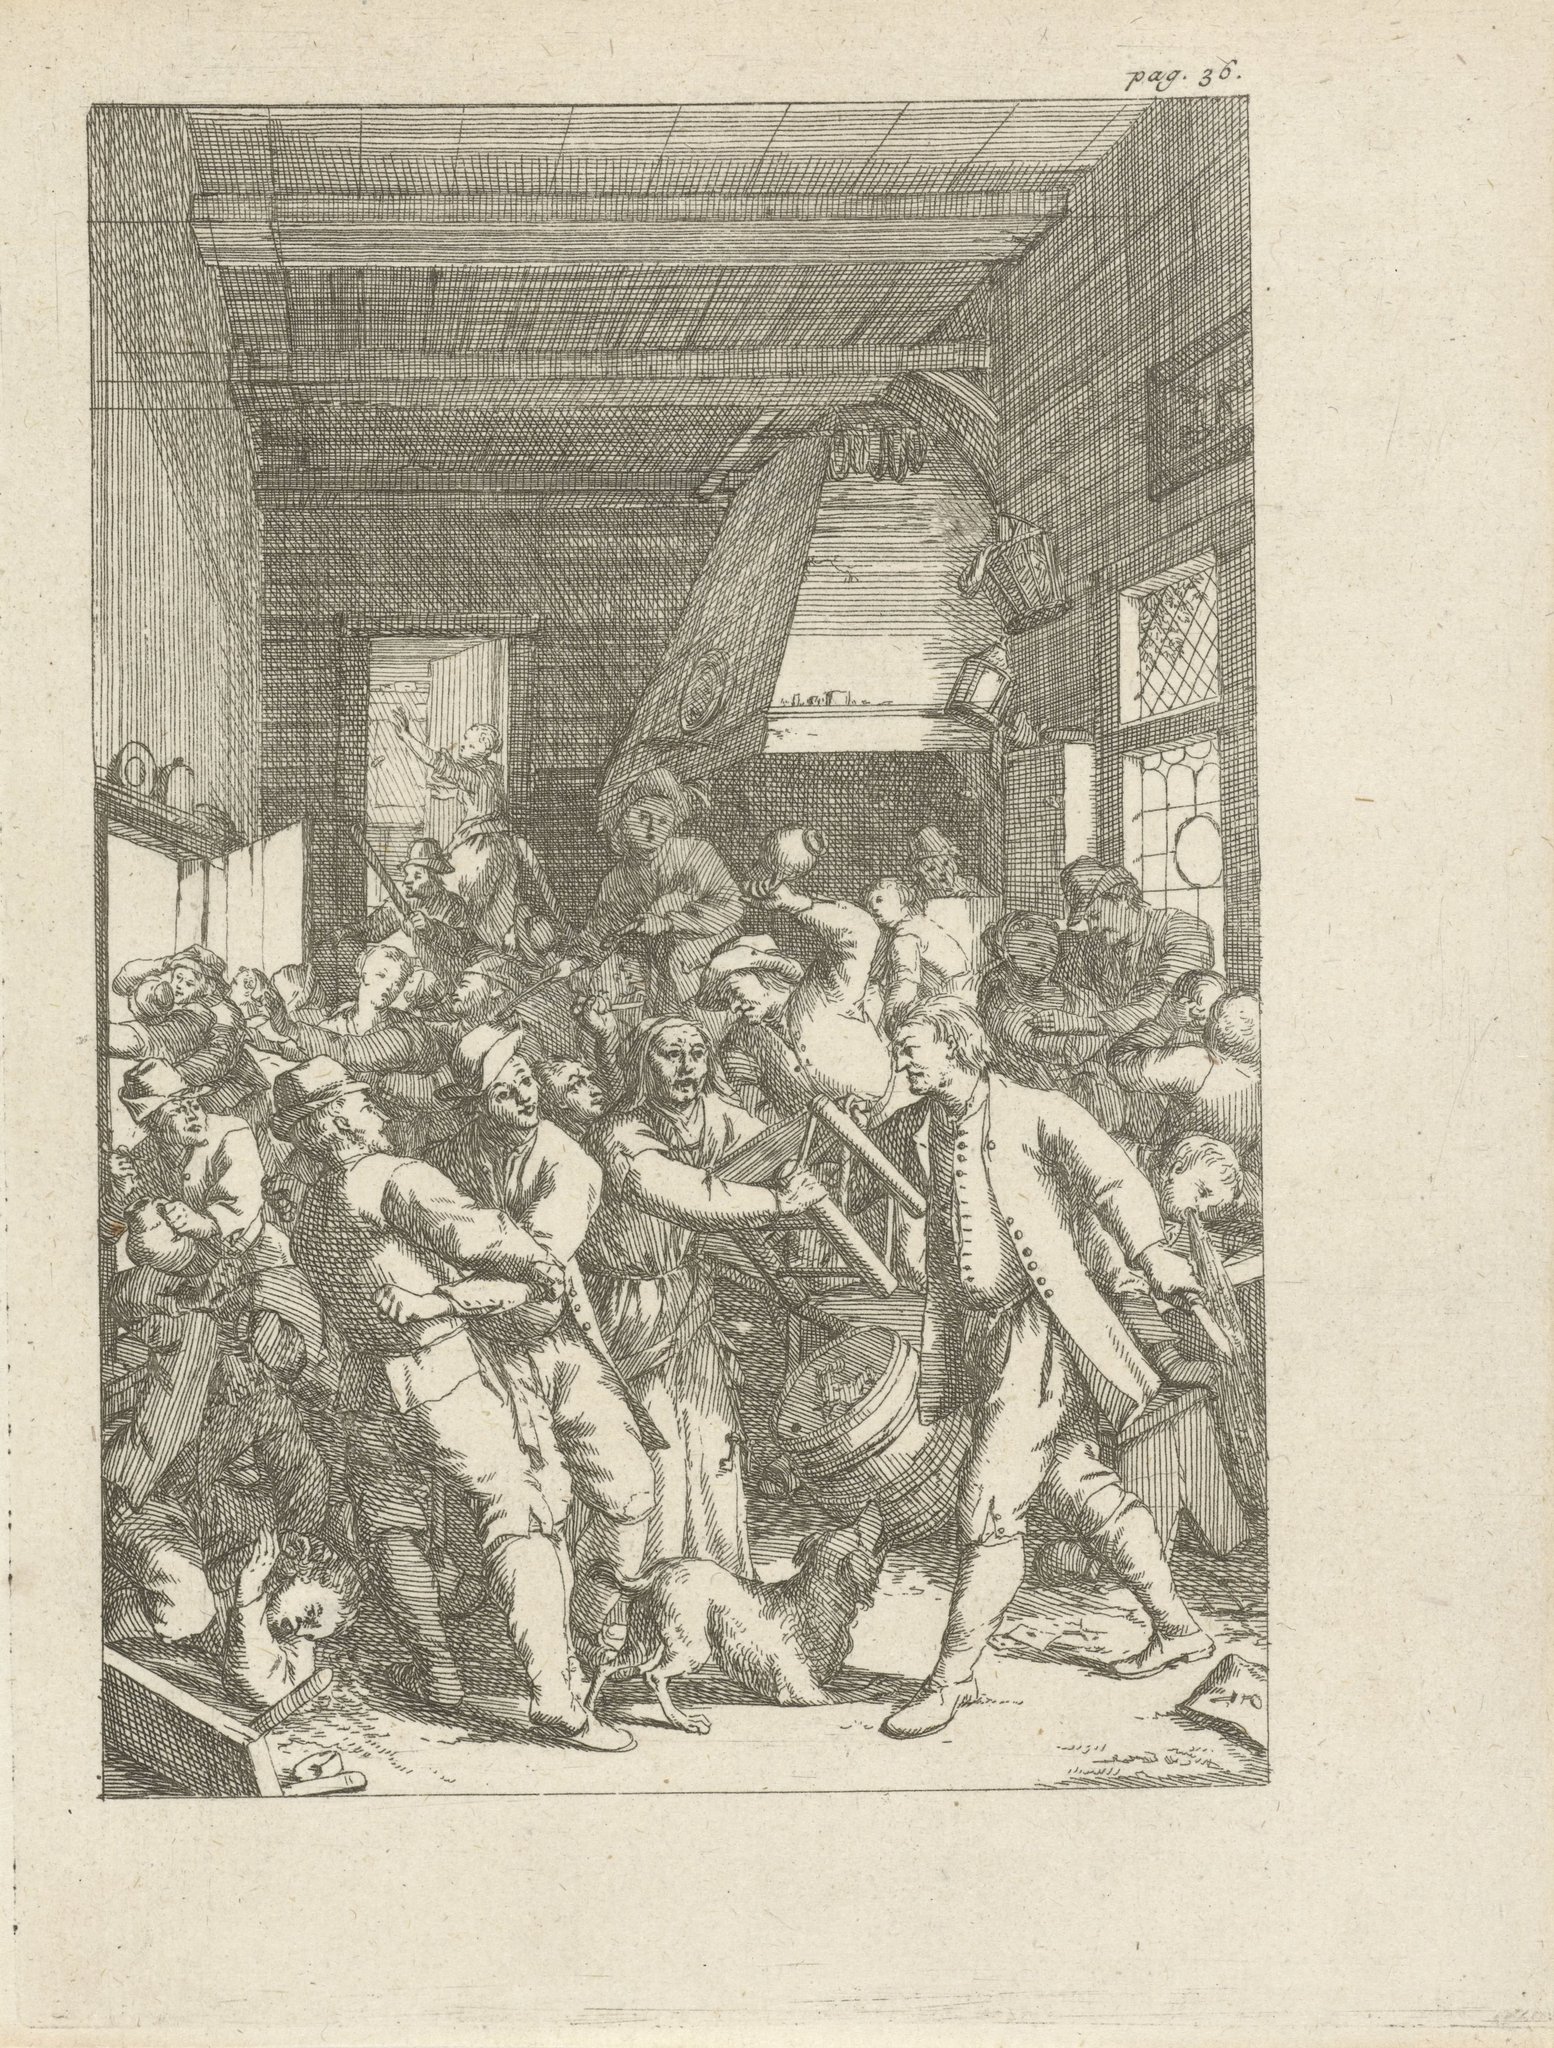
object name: book illustration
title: Gevecht in een herberg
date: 1733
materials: paper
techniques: etching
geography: rotterdam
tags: farmers, drunken brawl (usually peasants fighting in an inn)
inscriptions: collector's mark: Lugt 2228, collector's mark: Lugt 2760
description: Boekillustratie voor Frans Greenwood, Boerepinxtervreugt. Rotterdam bij Arnold Willis,1733.